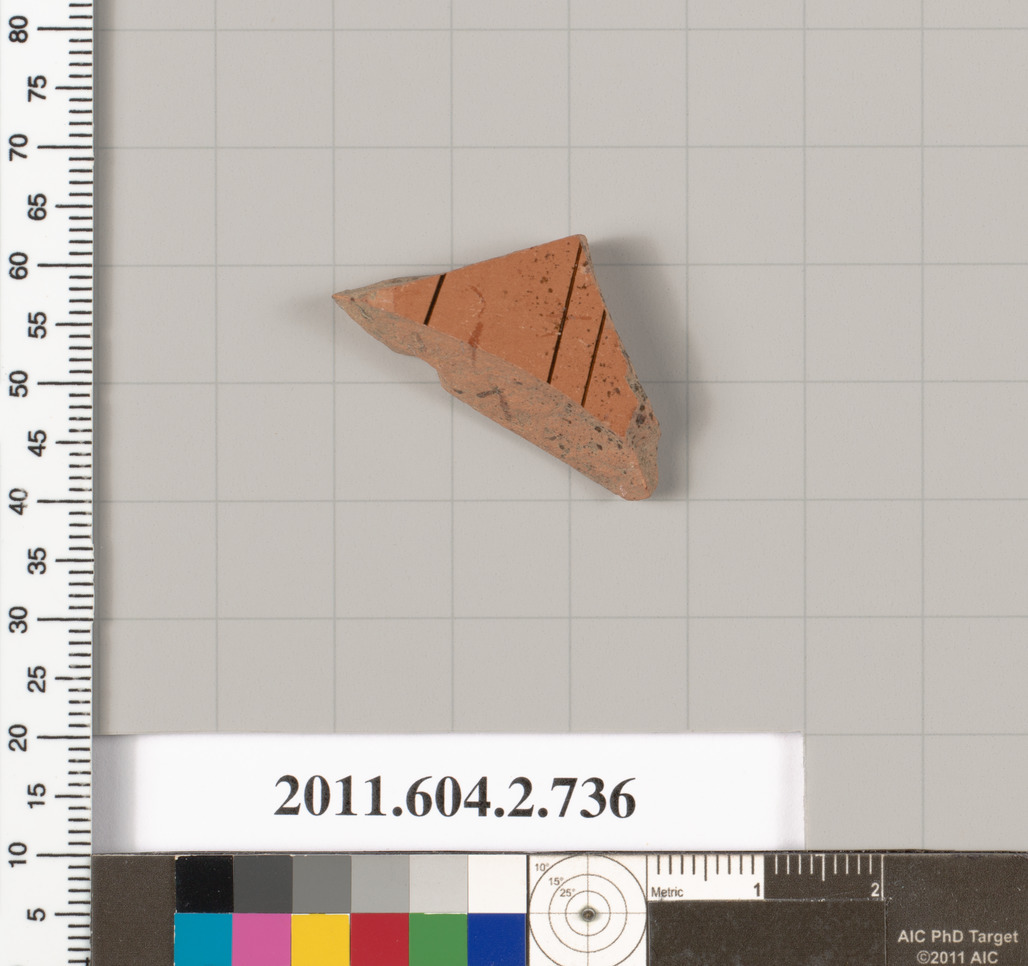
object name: calyx krater fragment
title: Terracotta fragment of a calyx-krater (bowl for mixing wine and water)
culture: greek, attic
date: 475-451 BCE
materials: terracotta